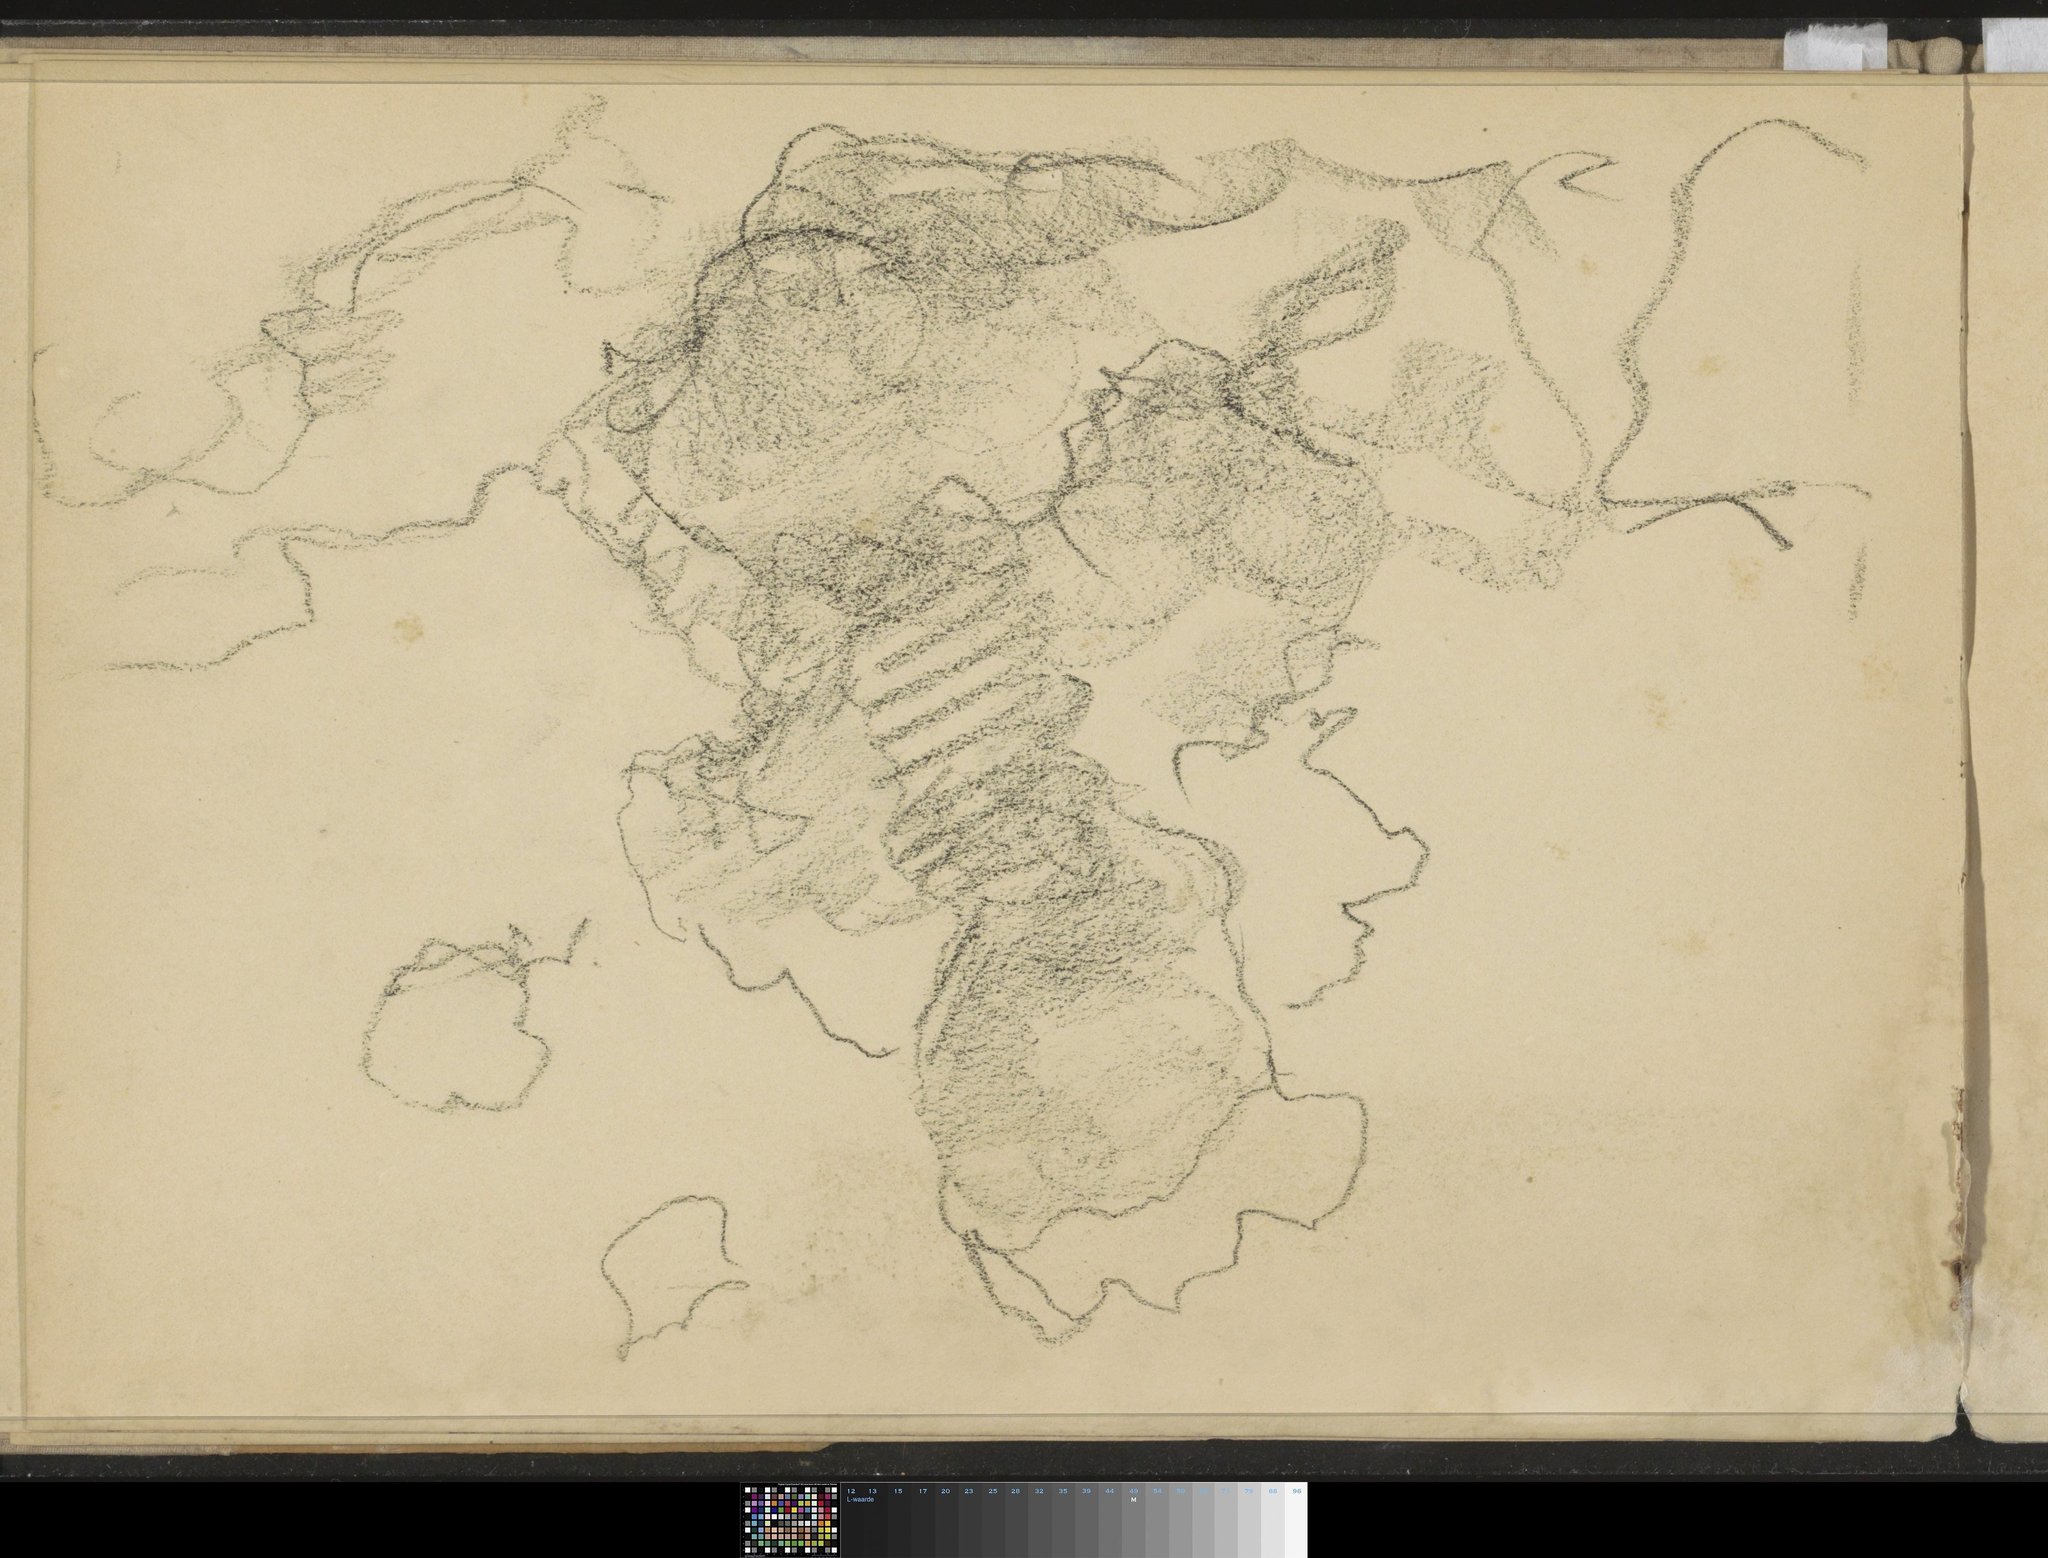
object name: sketchbook leaf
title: Wolken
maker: willem bastiaan tholen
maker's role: draughtsman, painter, print maker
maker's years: 1860-1931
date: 1885-1931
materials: chalk, paper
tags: clouds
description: Blad 14 verso uit een schetsboek met 28 bladen.